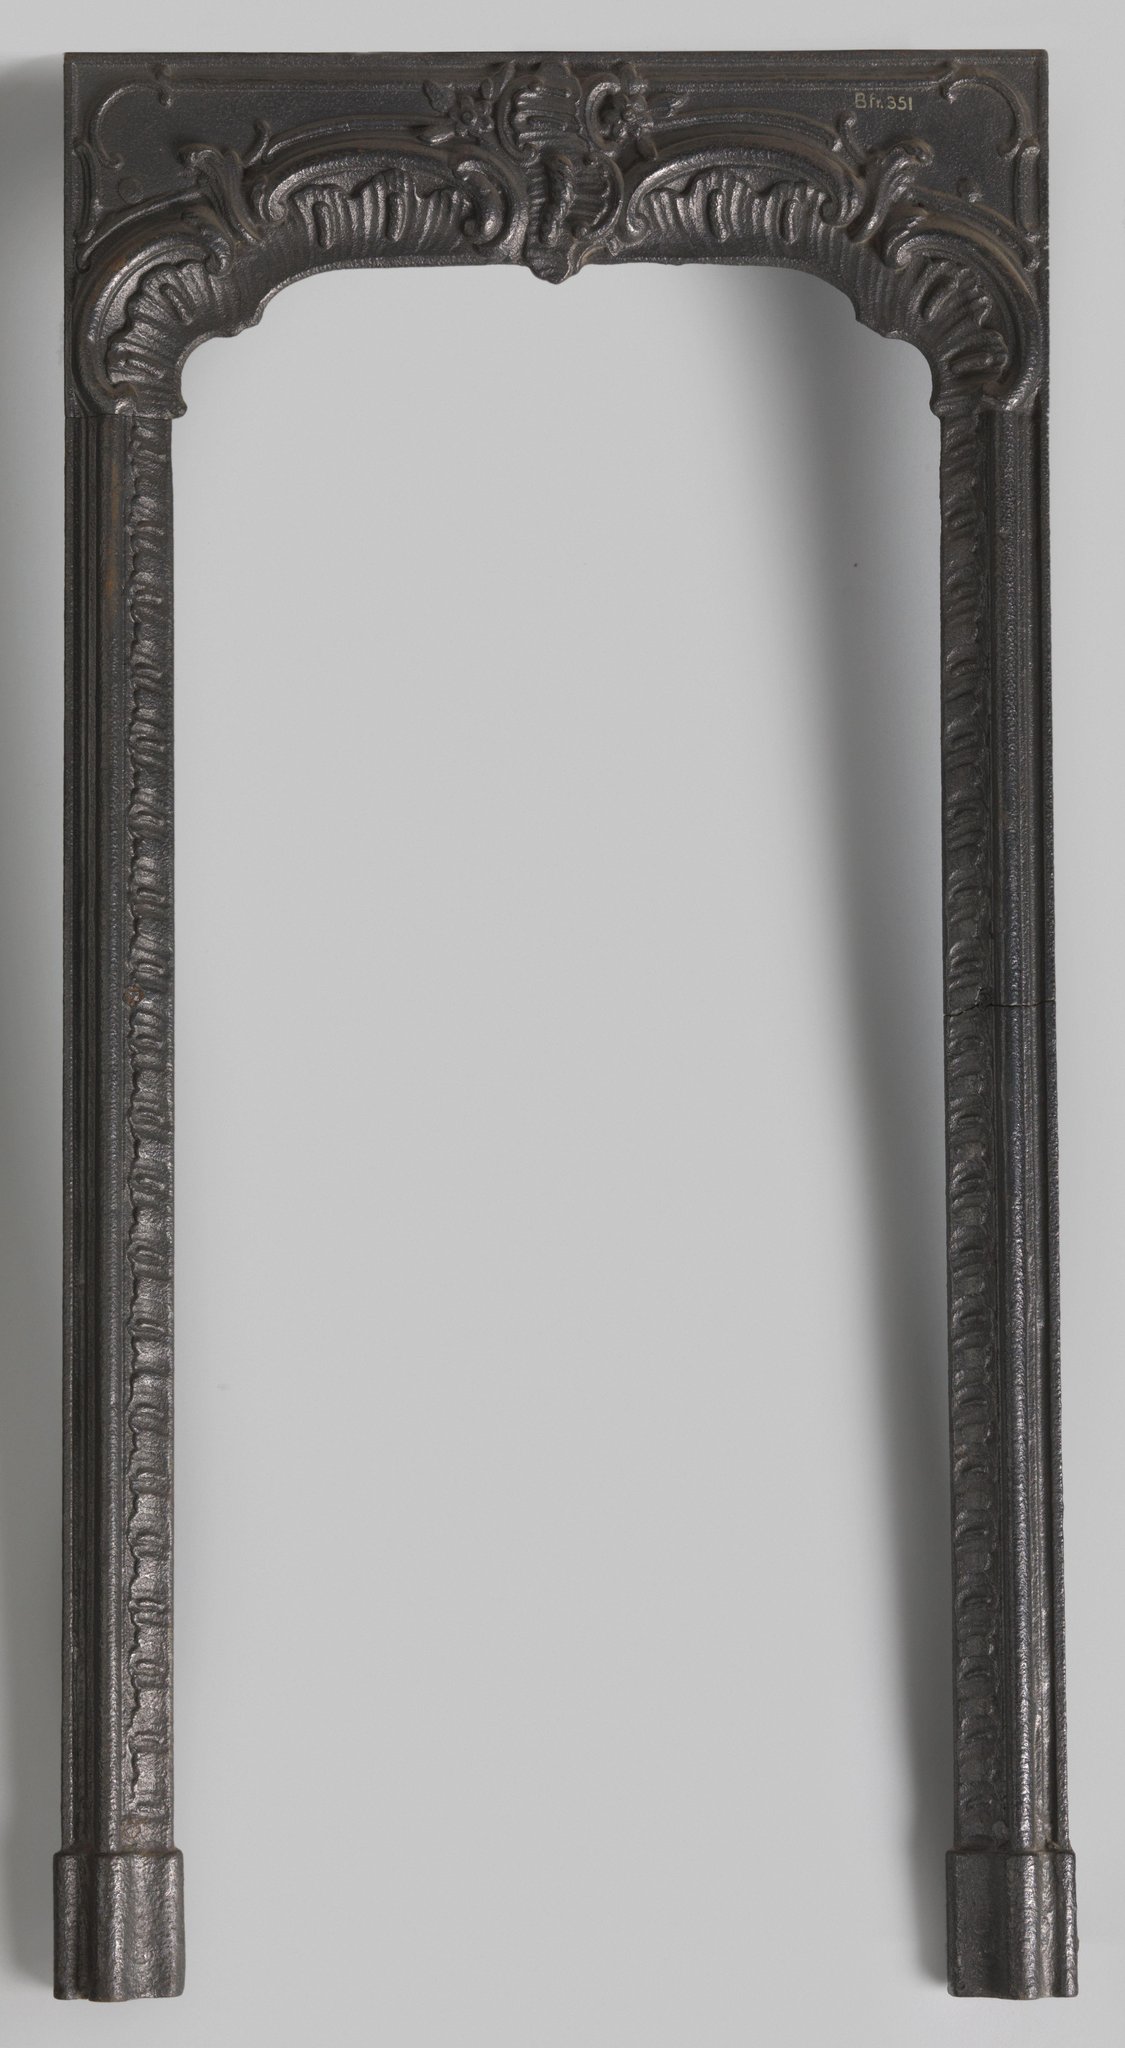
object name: haardombouw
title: Gietijzeren plaat voor ombouw van de haard, met rocailles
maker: Anonymous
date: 1725-1750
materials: iron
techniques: casting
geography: germany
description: Plaat van gietijzer, onderdeel van de haardombouw. De opening wordt omrandt met rocailleornamenten. Het geheel wordt bekroond met een groot rocailleornament.